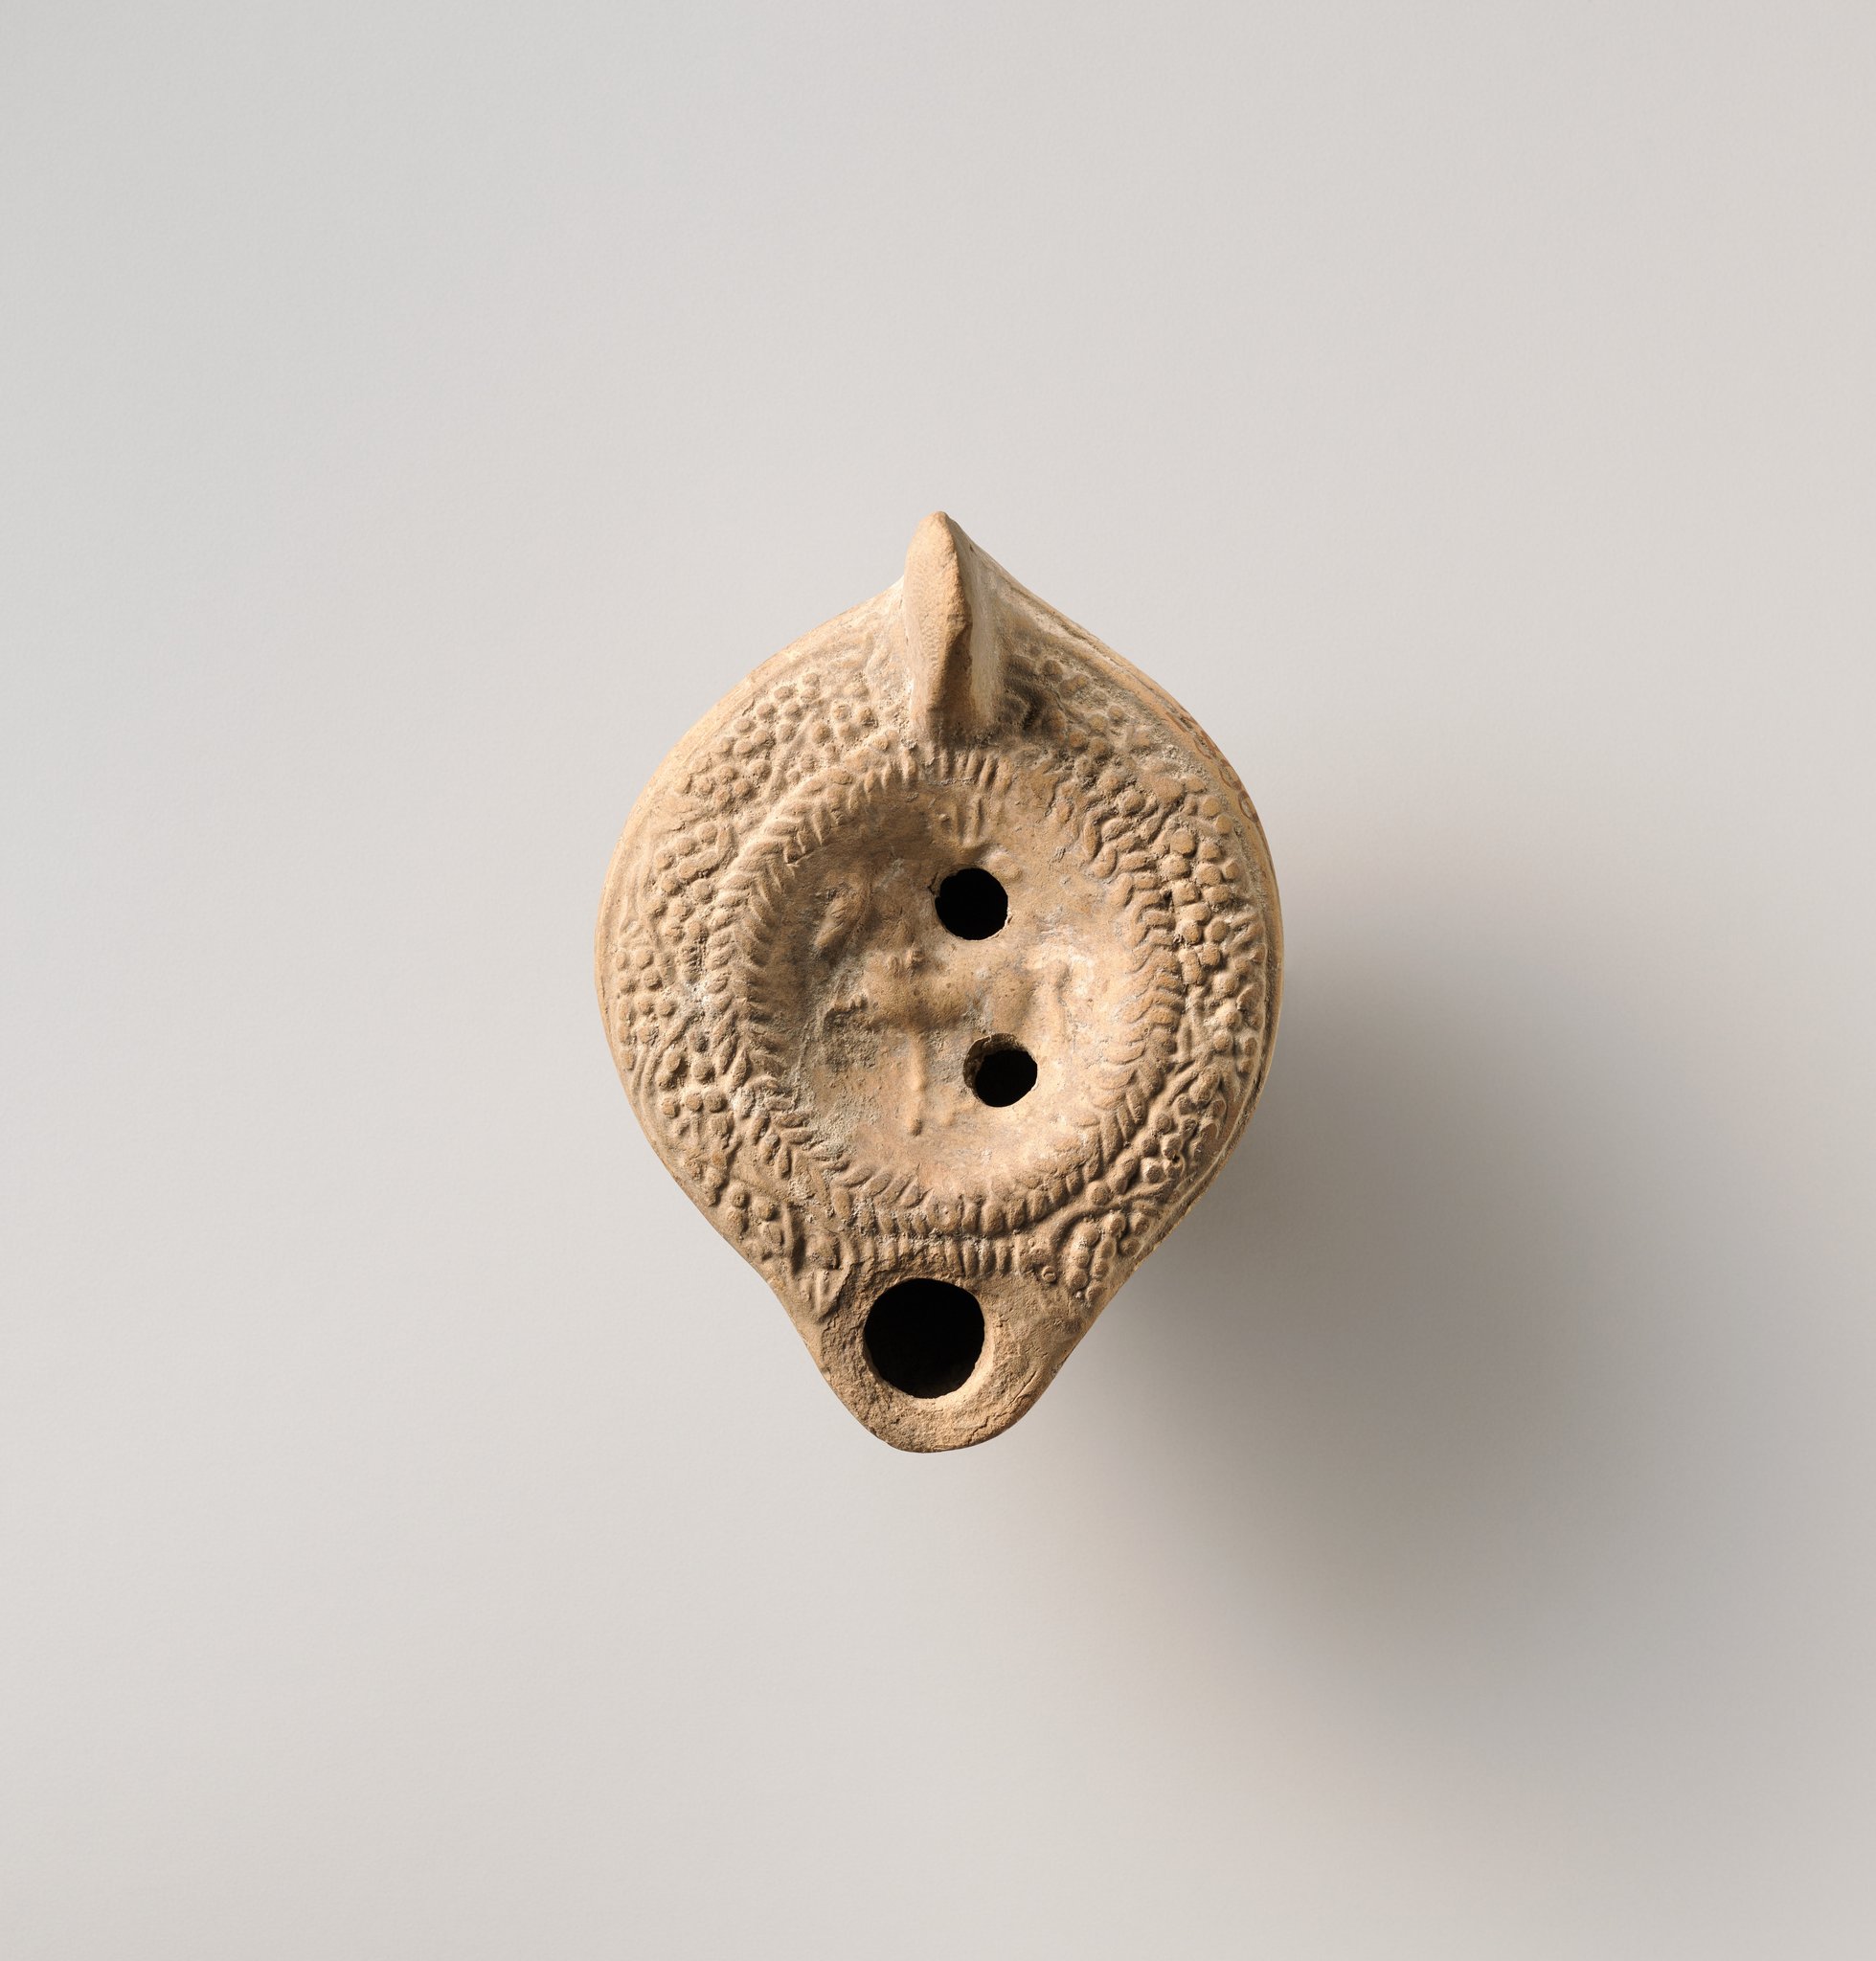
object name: lamp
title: Terracotta oil lamp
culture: roman, cypriot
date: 301-500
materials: terracotta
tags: horses